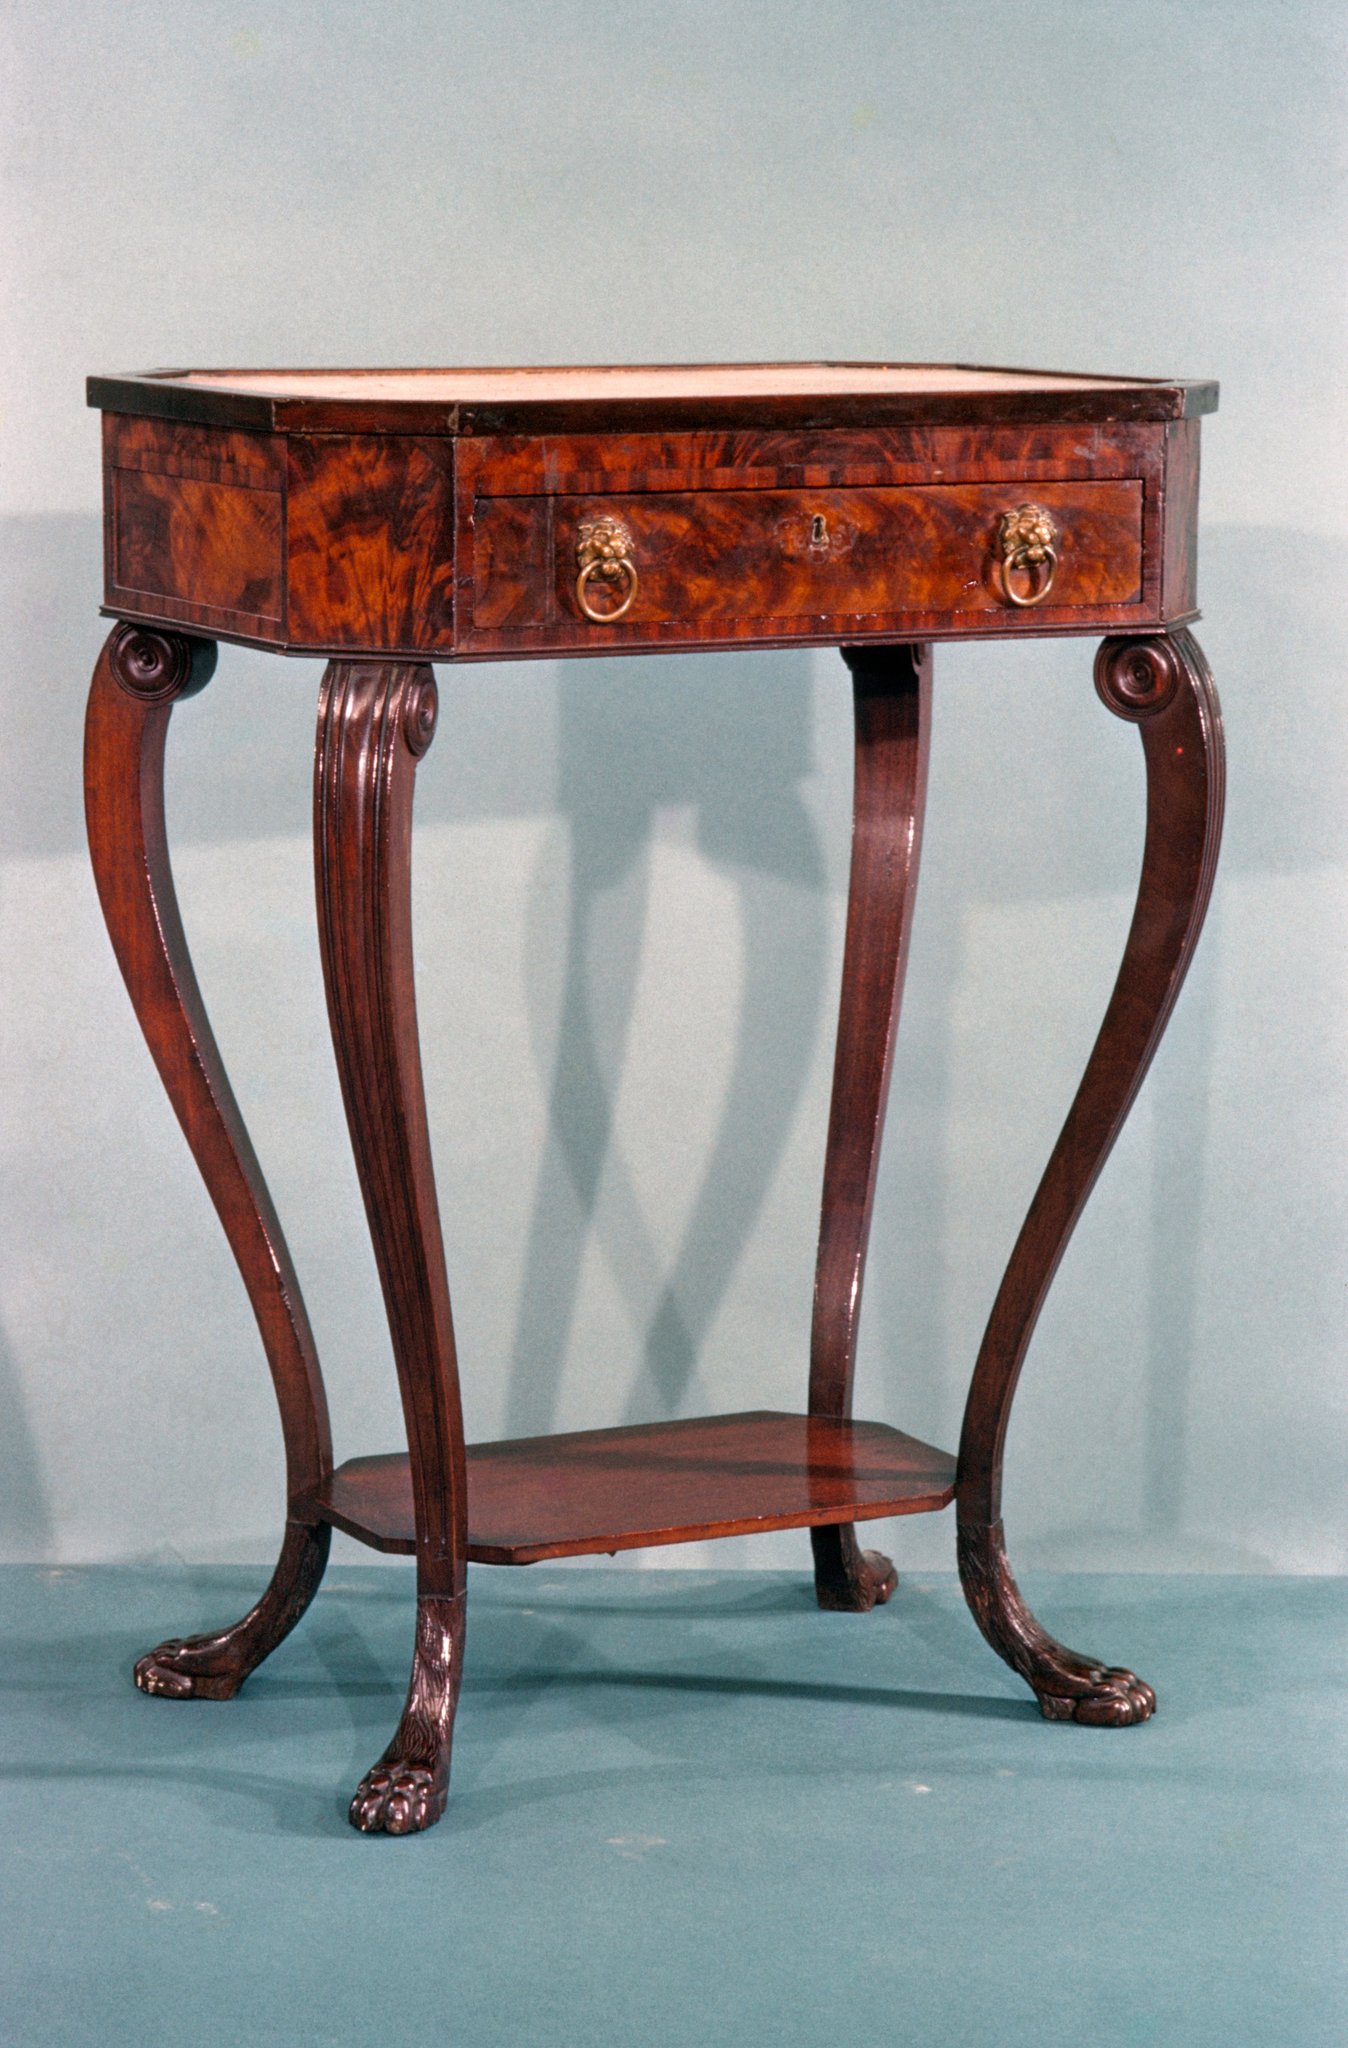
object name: kettle with stand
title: Kettle Stand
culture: american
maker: duncan phyfe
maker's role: maker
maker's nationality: american, born scotland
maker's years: 1770-1854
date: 1810-1820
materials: wood, marble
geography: united states